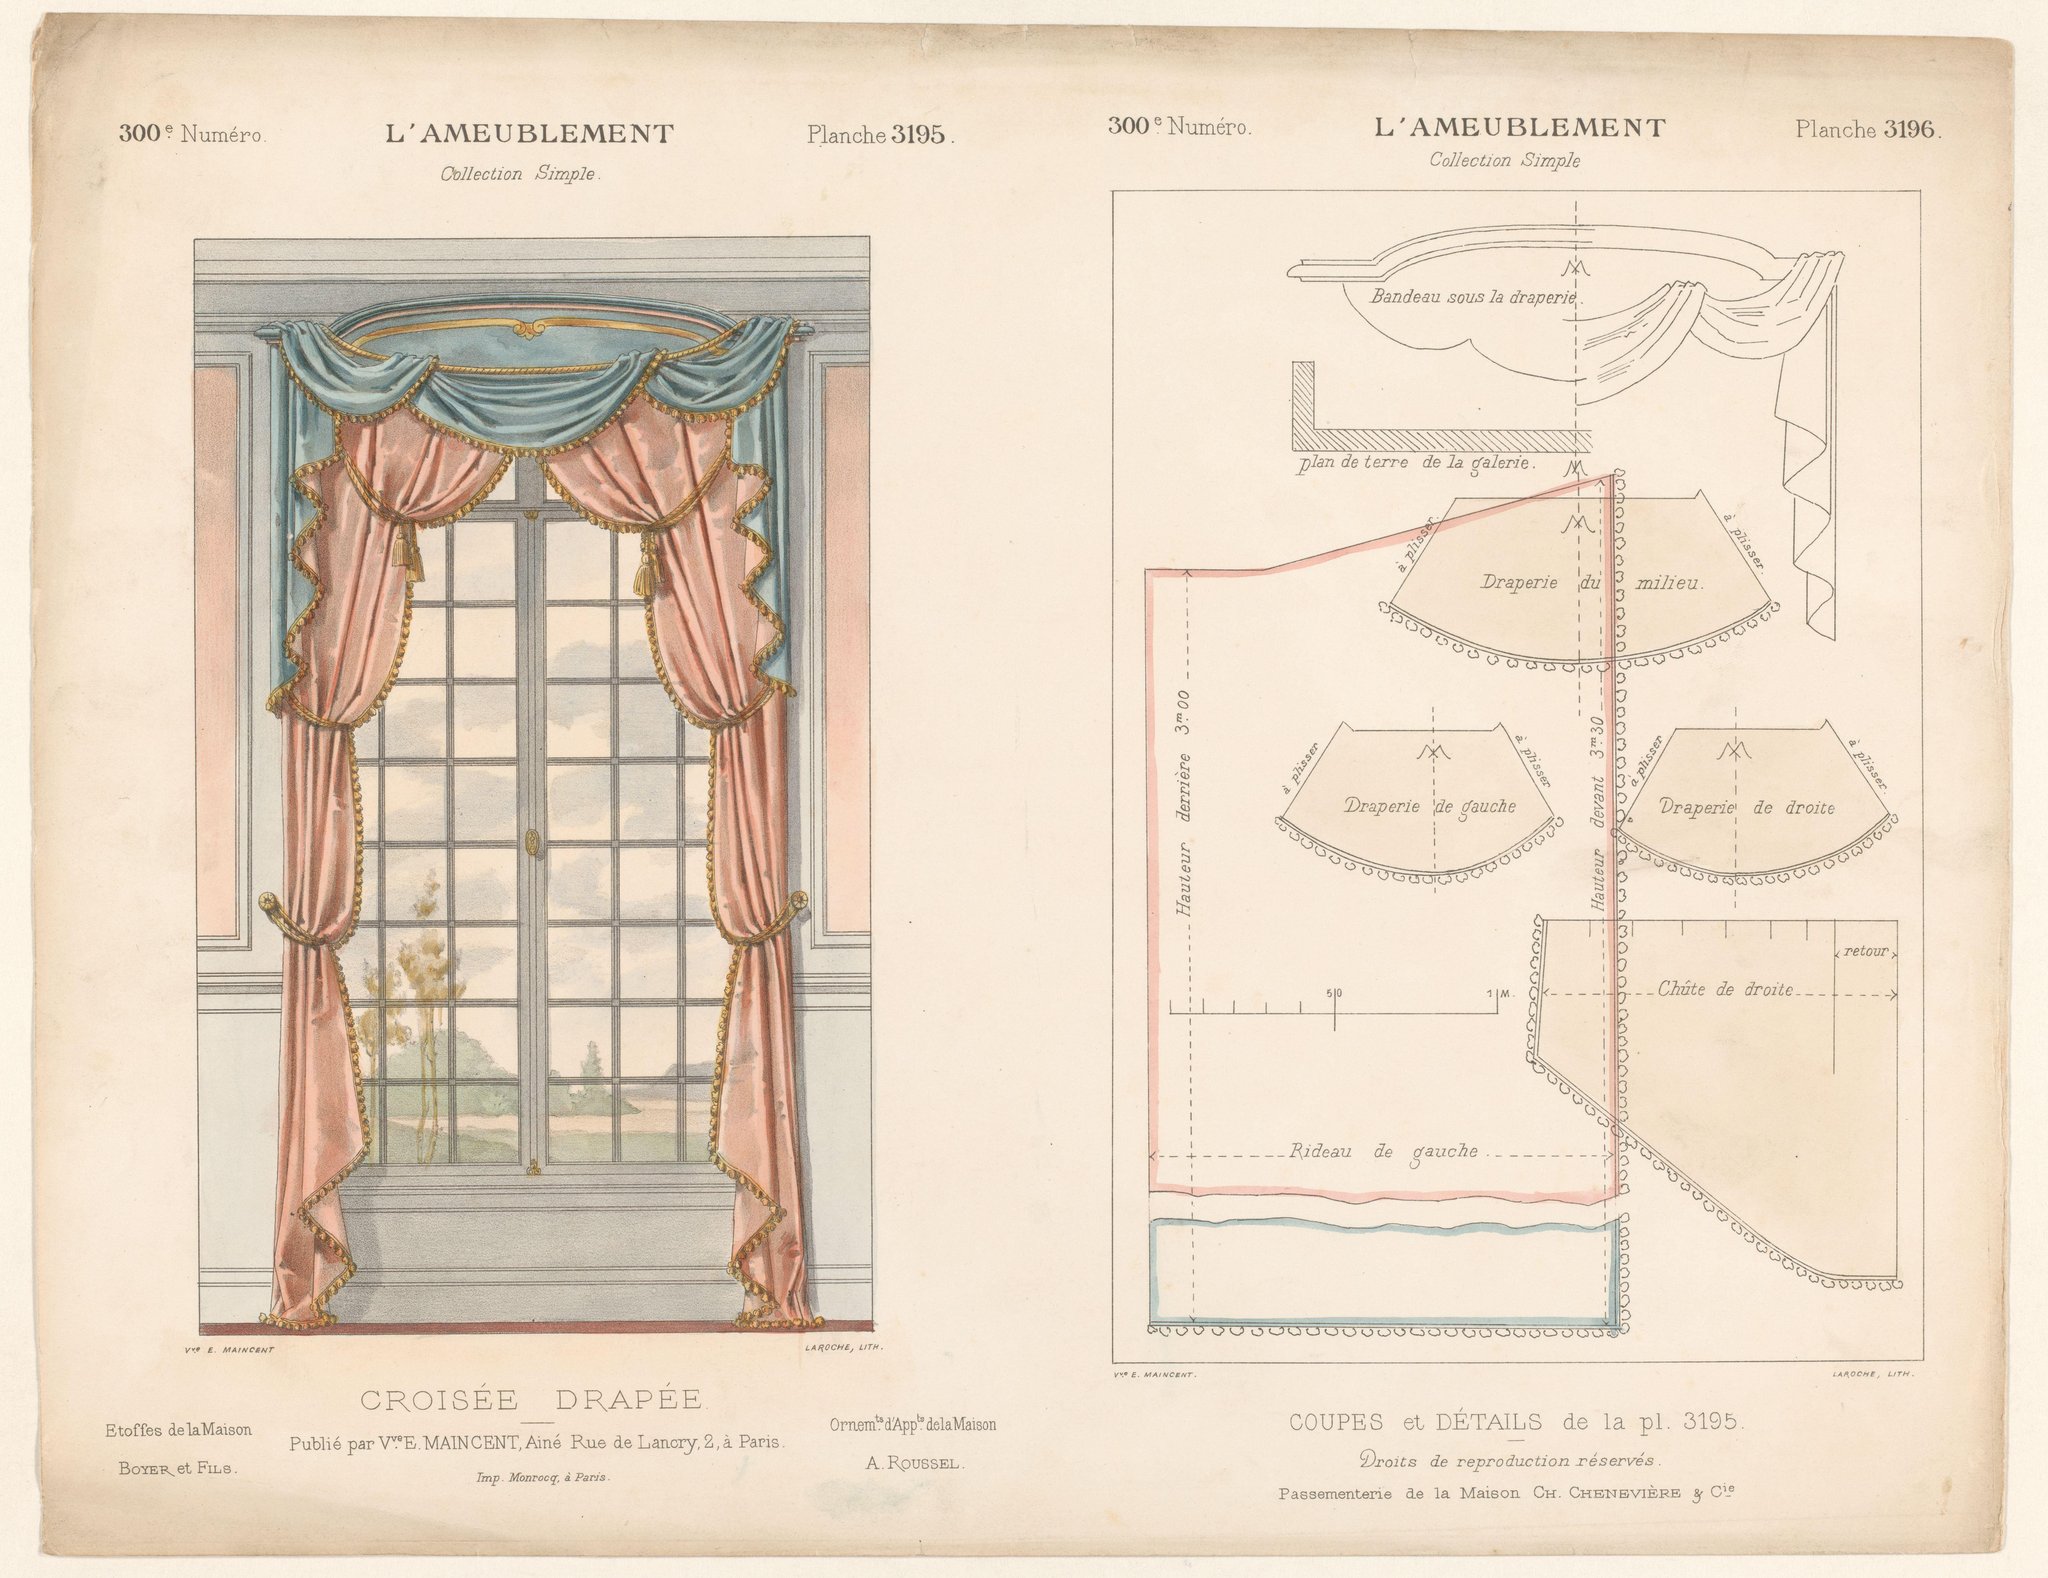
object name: print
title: L'ameublement / Collection simple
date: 1895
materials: paper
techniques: hand coloring, lithograph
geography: paris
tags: window, hangings and drapery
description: Een venster met gedrapeerde gordijnen. Rechts details van de draperieën. Prent uit 300e Livraison.